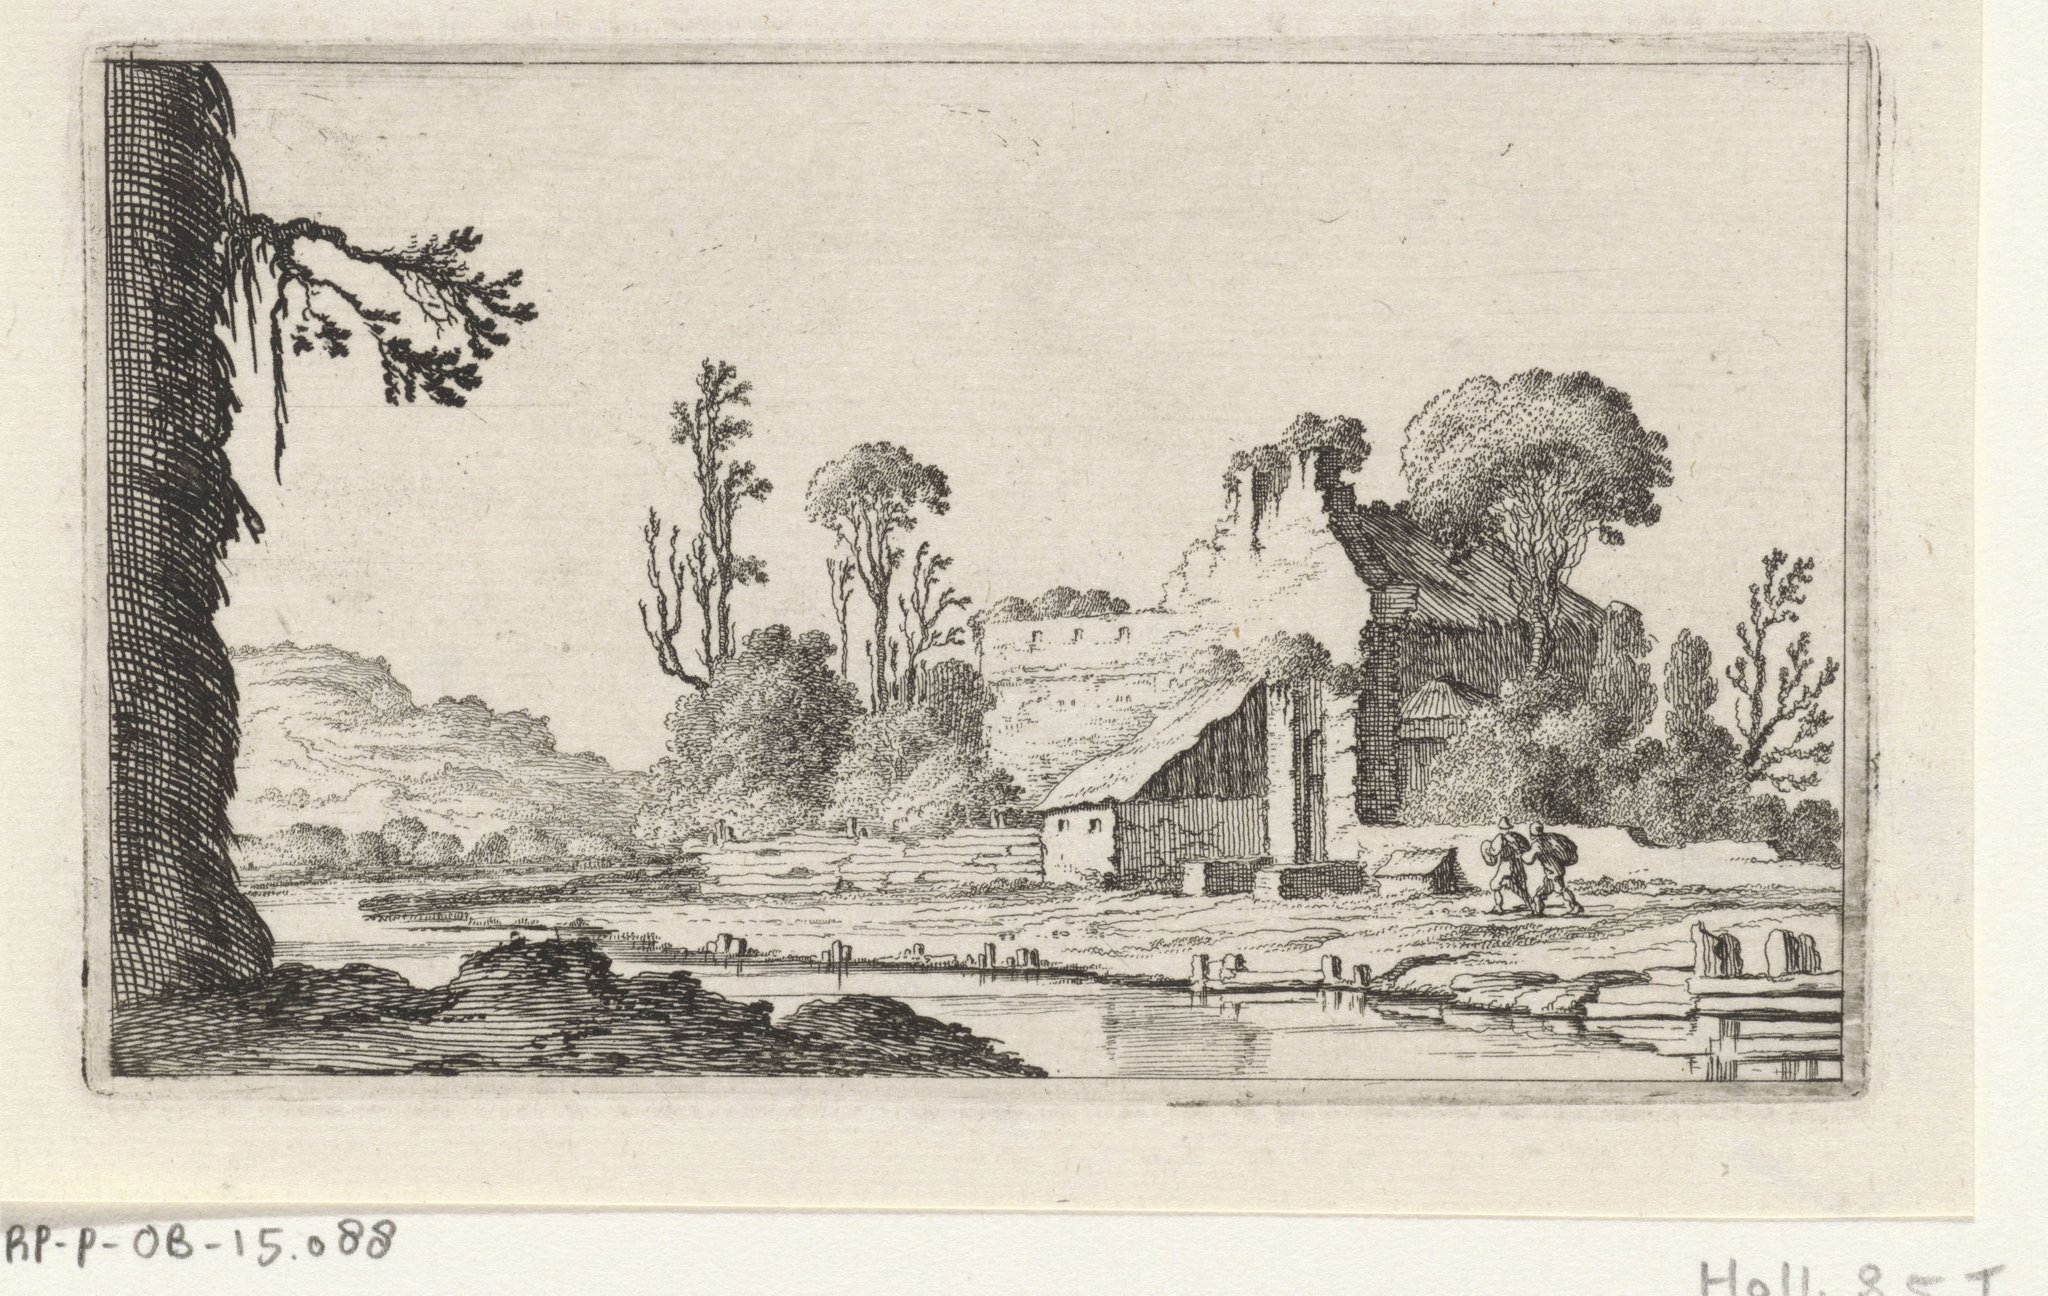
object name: print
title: Landschappen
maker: gillis van scheyndel (i)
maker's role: draughtsman, print maker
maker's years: 1595-1660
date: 1605-1653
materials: paper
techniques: engraving, etching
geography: netherlands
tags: river, farm or solitary house in landscape, farm (building)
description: Aan een rivier ligt een tot boerderij omgebouwde ruïne. Aan de waterkant twee figuren met bagage. De prent maakt deel uit van een serie van twaalf landschappen.